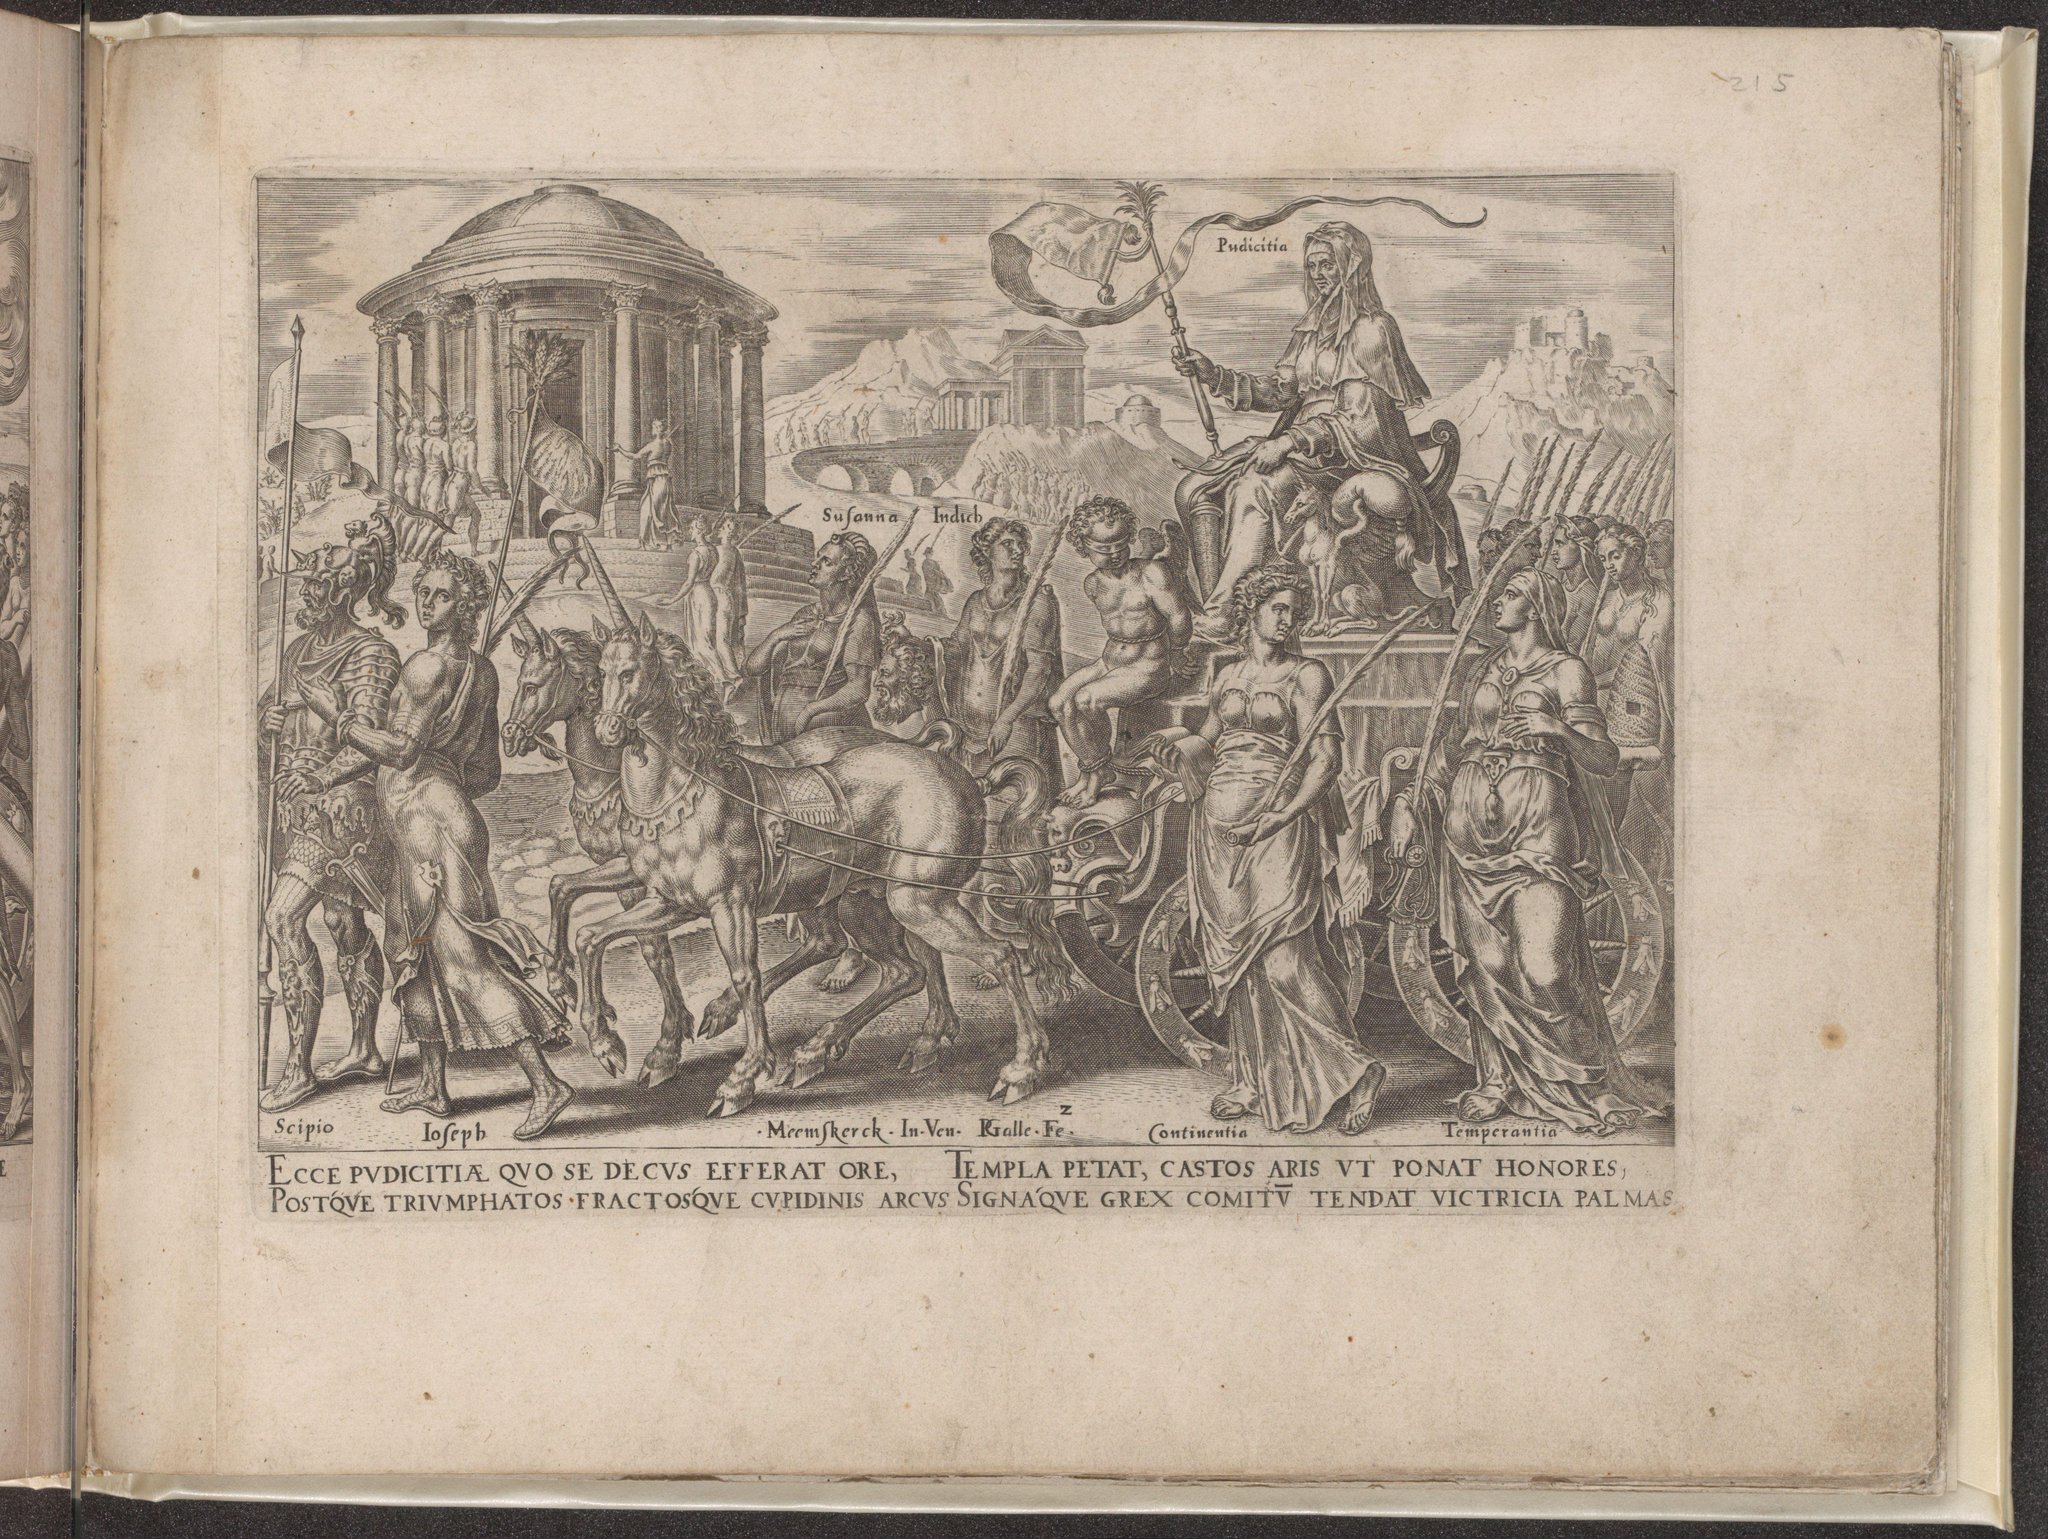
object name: print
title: Triomfen van Petrarca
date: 1563-1567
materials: paper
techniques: engraving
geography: haarlem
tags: temperance, 'temperantia'; 'temperanza' (ripa) ~ one of the four cardinal virtues, 'trionfo della castità', 'triumphus pudicitiae'; 'carro della castità' (ripa), (story of) p. cornelius scipio africanus minor (p. cornelius scipio aemilianus), constancy, tenacity; 'costanza', 'tenacità' (ripa), female persons from the old testament (with name) (not in biblical context), joseph (not in biblical context)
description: De wagen van Kuisheid (Pudicitia), een gesluierde vrouw, wordt getrokken door eenhoorns, legendarische kuise dieren. Amor zit geblinddoekt en vastgebonden aan haar voeten. In de stoet lopen kuise figuren uit de geschiedenis, de Bijbel en de klassieke mythologie, bijvoorbeeld de Romeinse veldheer Scipio, Jozef, Susanna en de eerzame Judit, met in haar hand het hoofd van Holofernes. Ook de deugden Zelfbeheersing (Continentia) en Matigheid (Temperantia) zijn in de stoet aanwezig. De wagen rijdt richting de tempel van Kuisheid. Onder de voorstelling een verklarende tekst in het Latijn. Deze prent maakt deel uit van een album.